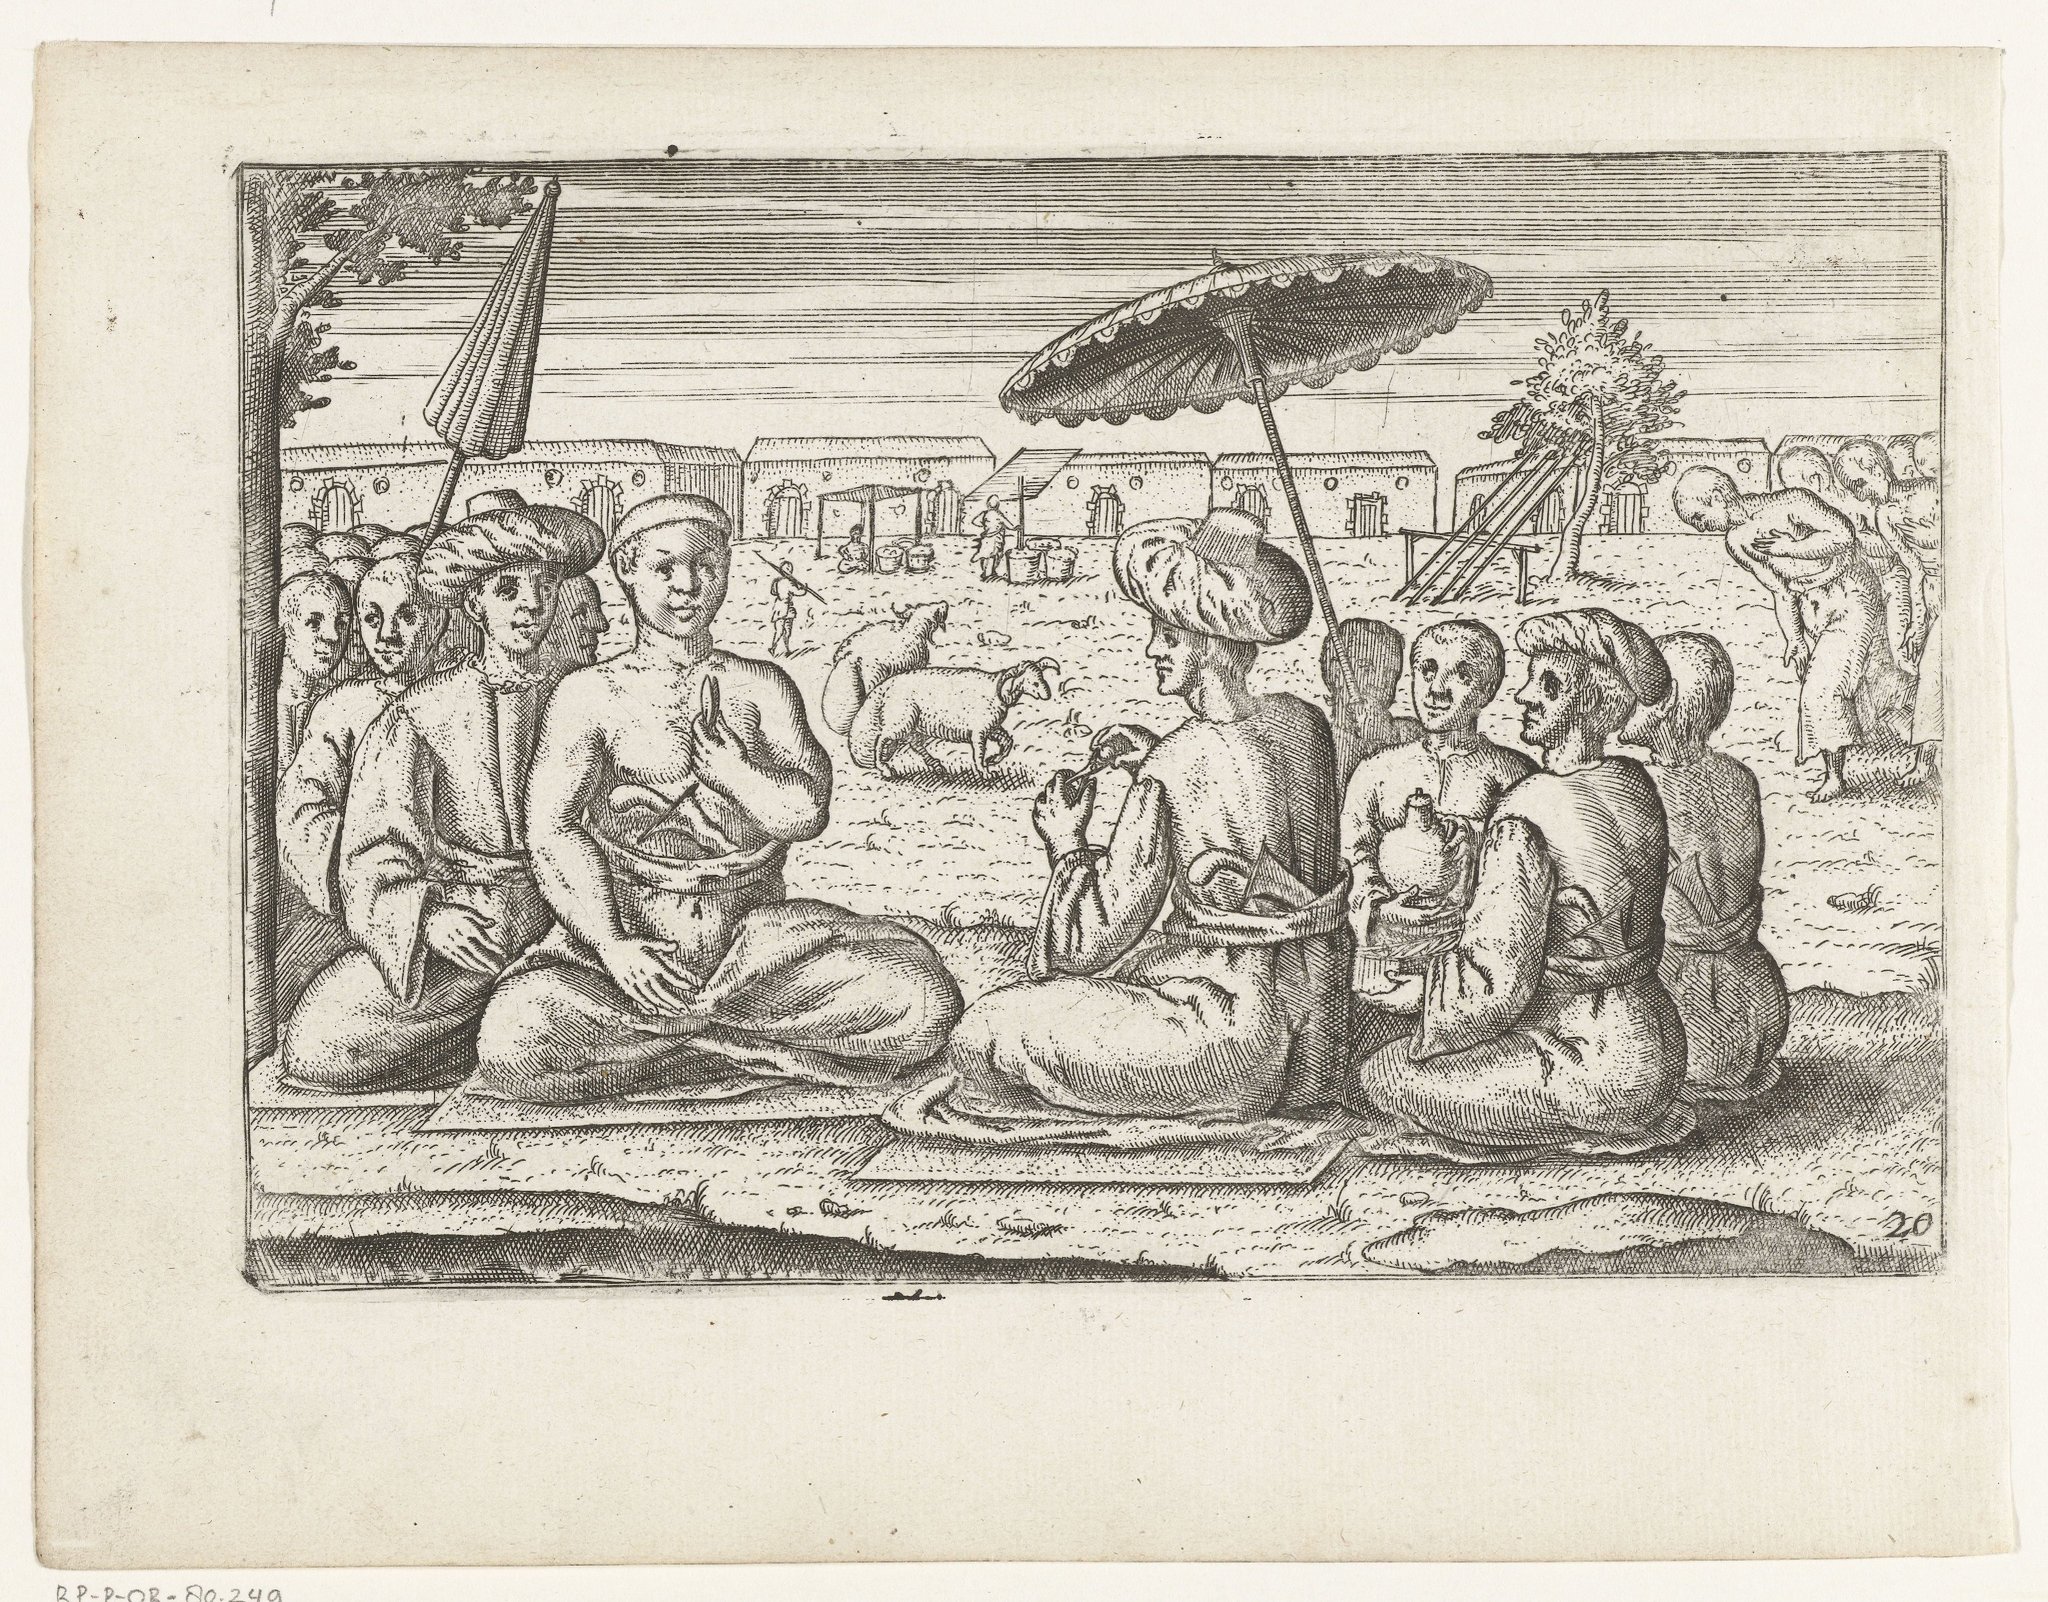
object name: print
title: De gouverneur (Ki Patih) en de opper-Sjaich (Kali) van Bantam, 1596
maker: Anonymous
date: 1597-1598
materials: paper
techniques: engraving, etching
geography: northern netherlands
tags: gouda, landscapes in tropical and sub-tropical regions, exploration, expedition, voyage of discovery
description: Gebruikt als illustratie eerst in: Willem Lodewijcksz, D'eerste boeck. Historie van Indien, waer inne verhaelt is de avontueren die de Hollandtsche schepen bejeghent zijn, Cornelis Claes, Amsterdam 1598. In deze opgewerkte staat gebruikt in: De Eerste Schipvaerd der Hollandsche Natie naer Oost-Indien, waer inne verhaelt wordt al wat haer sonderlings onder wegen bejegent is ... ghetrocken uyt verscheyden Iournalen ofte dagh-registers daer van ghemaeckt, zeer vermaeckelijck ende nut om lesen. Opgenomen in: I. Commelin, Begin ende voortgangh, van de Vereenighde Nederlantsche Geoctroyeerde Oost-Indische Compagnie, J. Janssonius, Amsterdam 1646. Genummerd: 20.